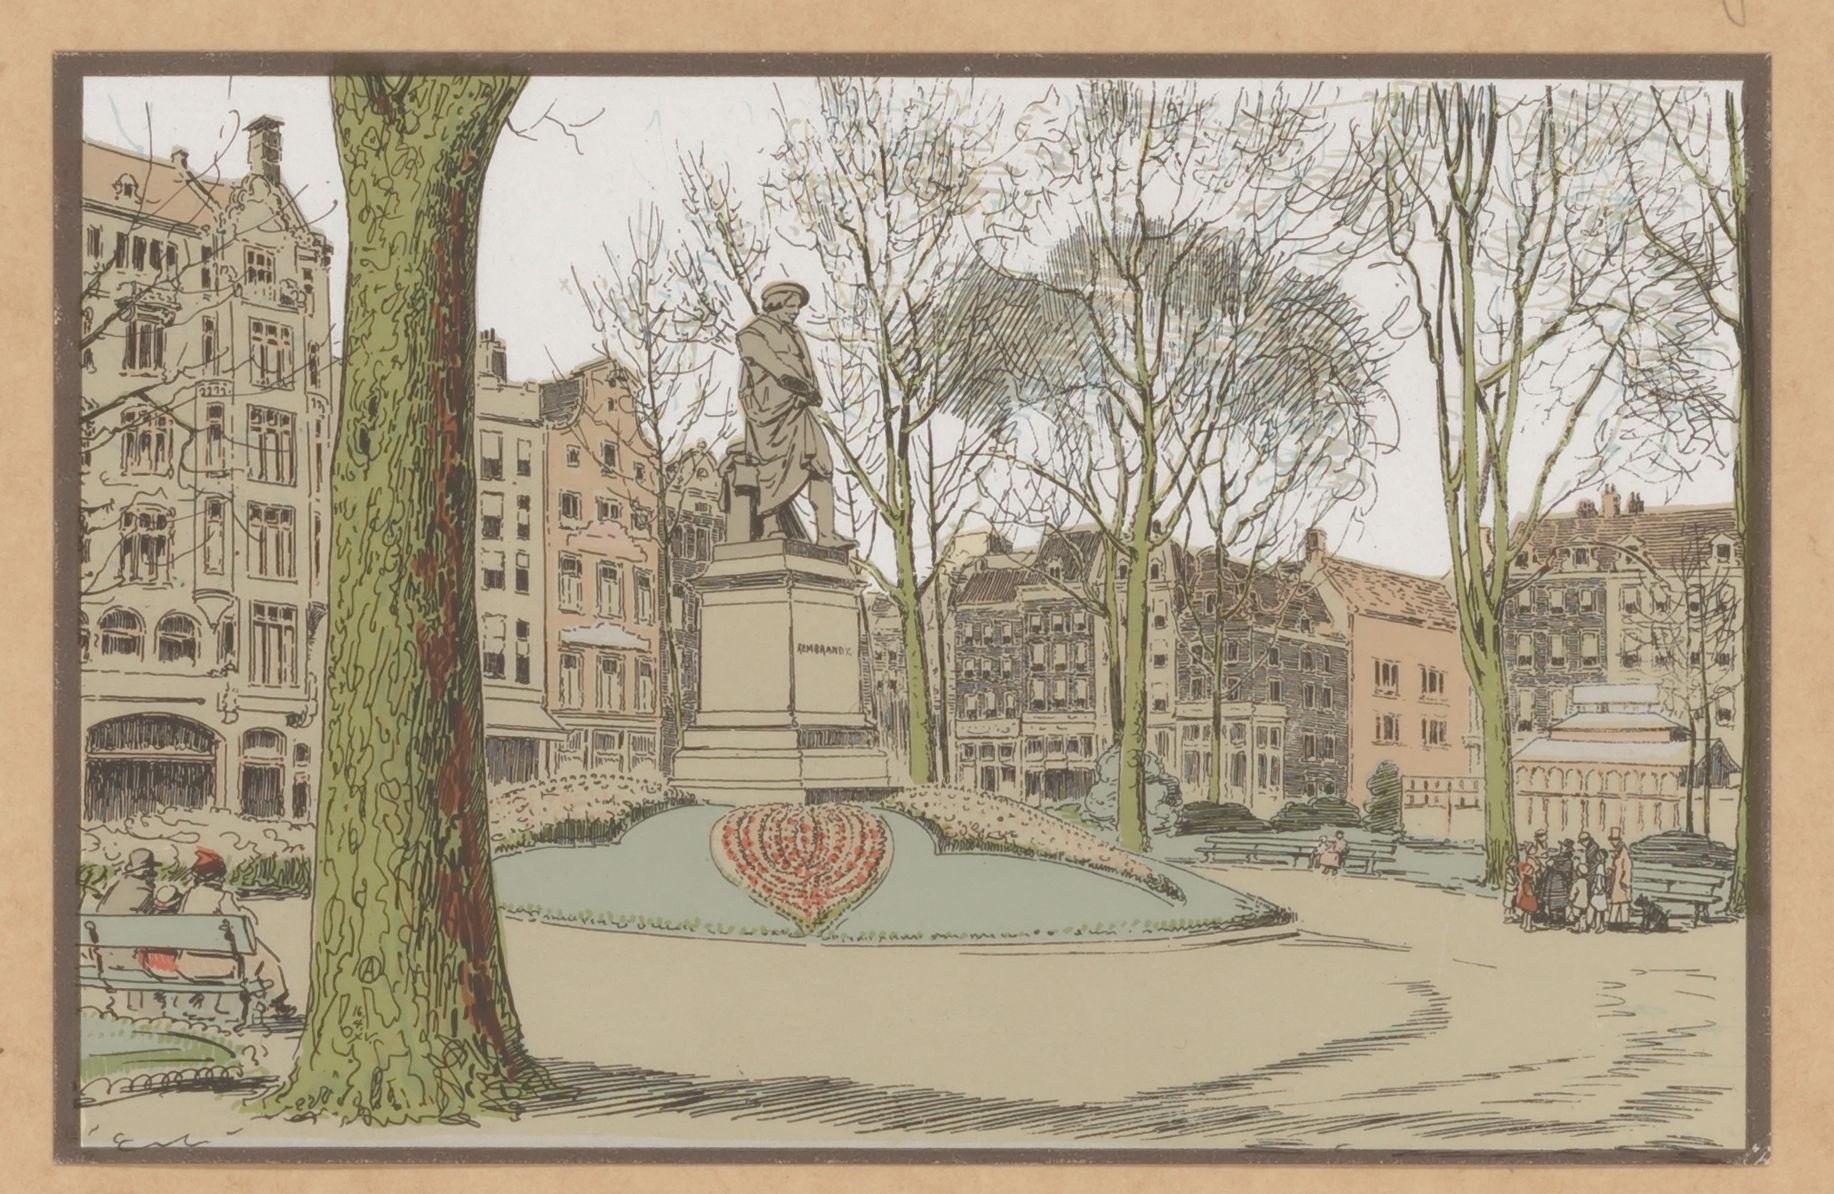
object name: photomechanical print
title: Gezicht op het Rembrandtplein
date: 1915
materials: cardboard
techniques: line block, printing block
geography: utrecht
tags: square, place, circus, etc., city-view in general; 'veduta', monument, statue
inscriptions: collector's mark: ‘3-44’ Lugt 1641b, signature: ‘A’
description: Onderwerpsrubriek binnen de Atlas Amsterdam: Panorama's en verzamelprenten.